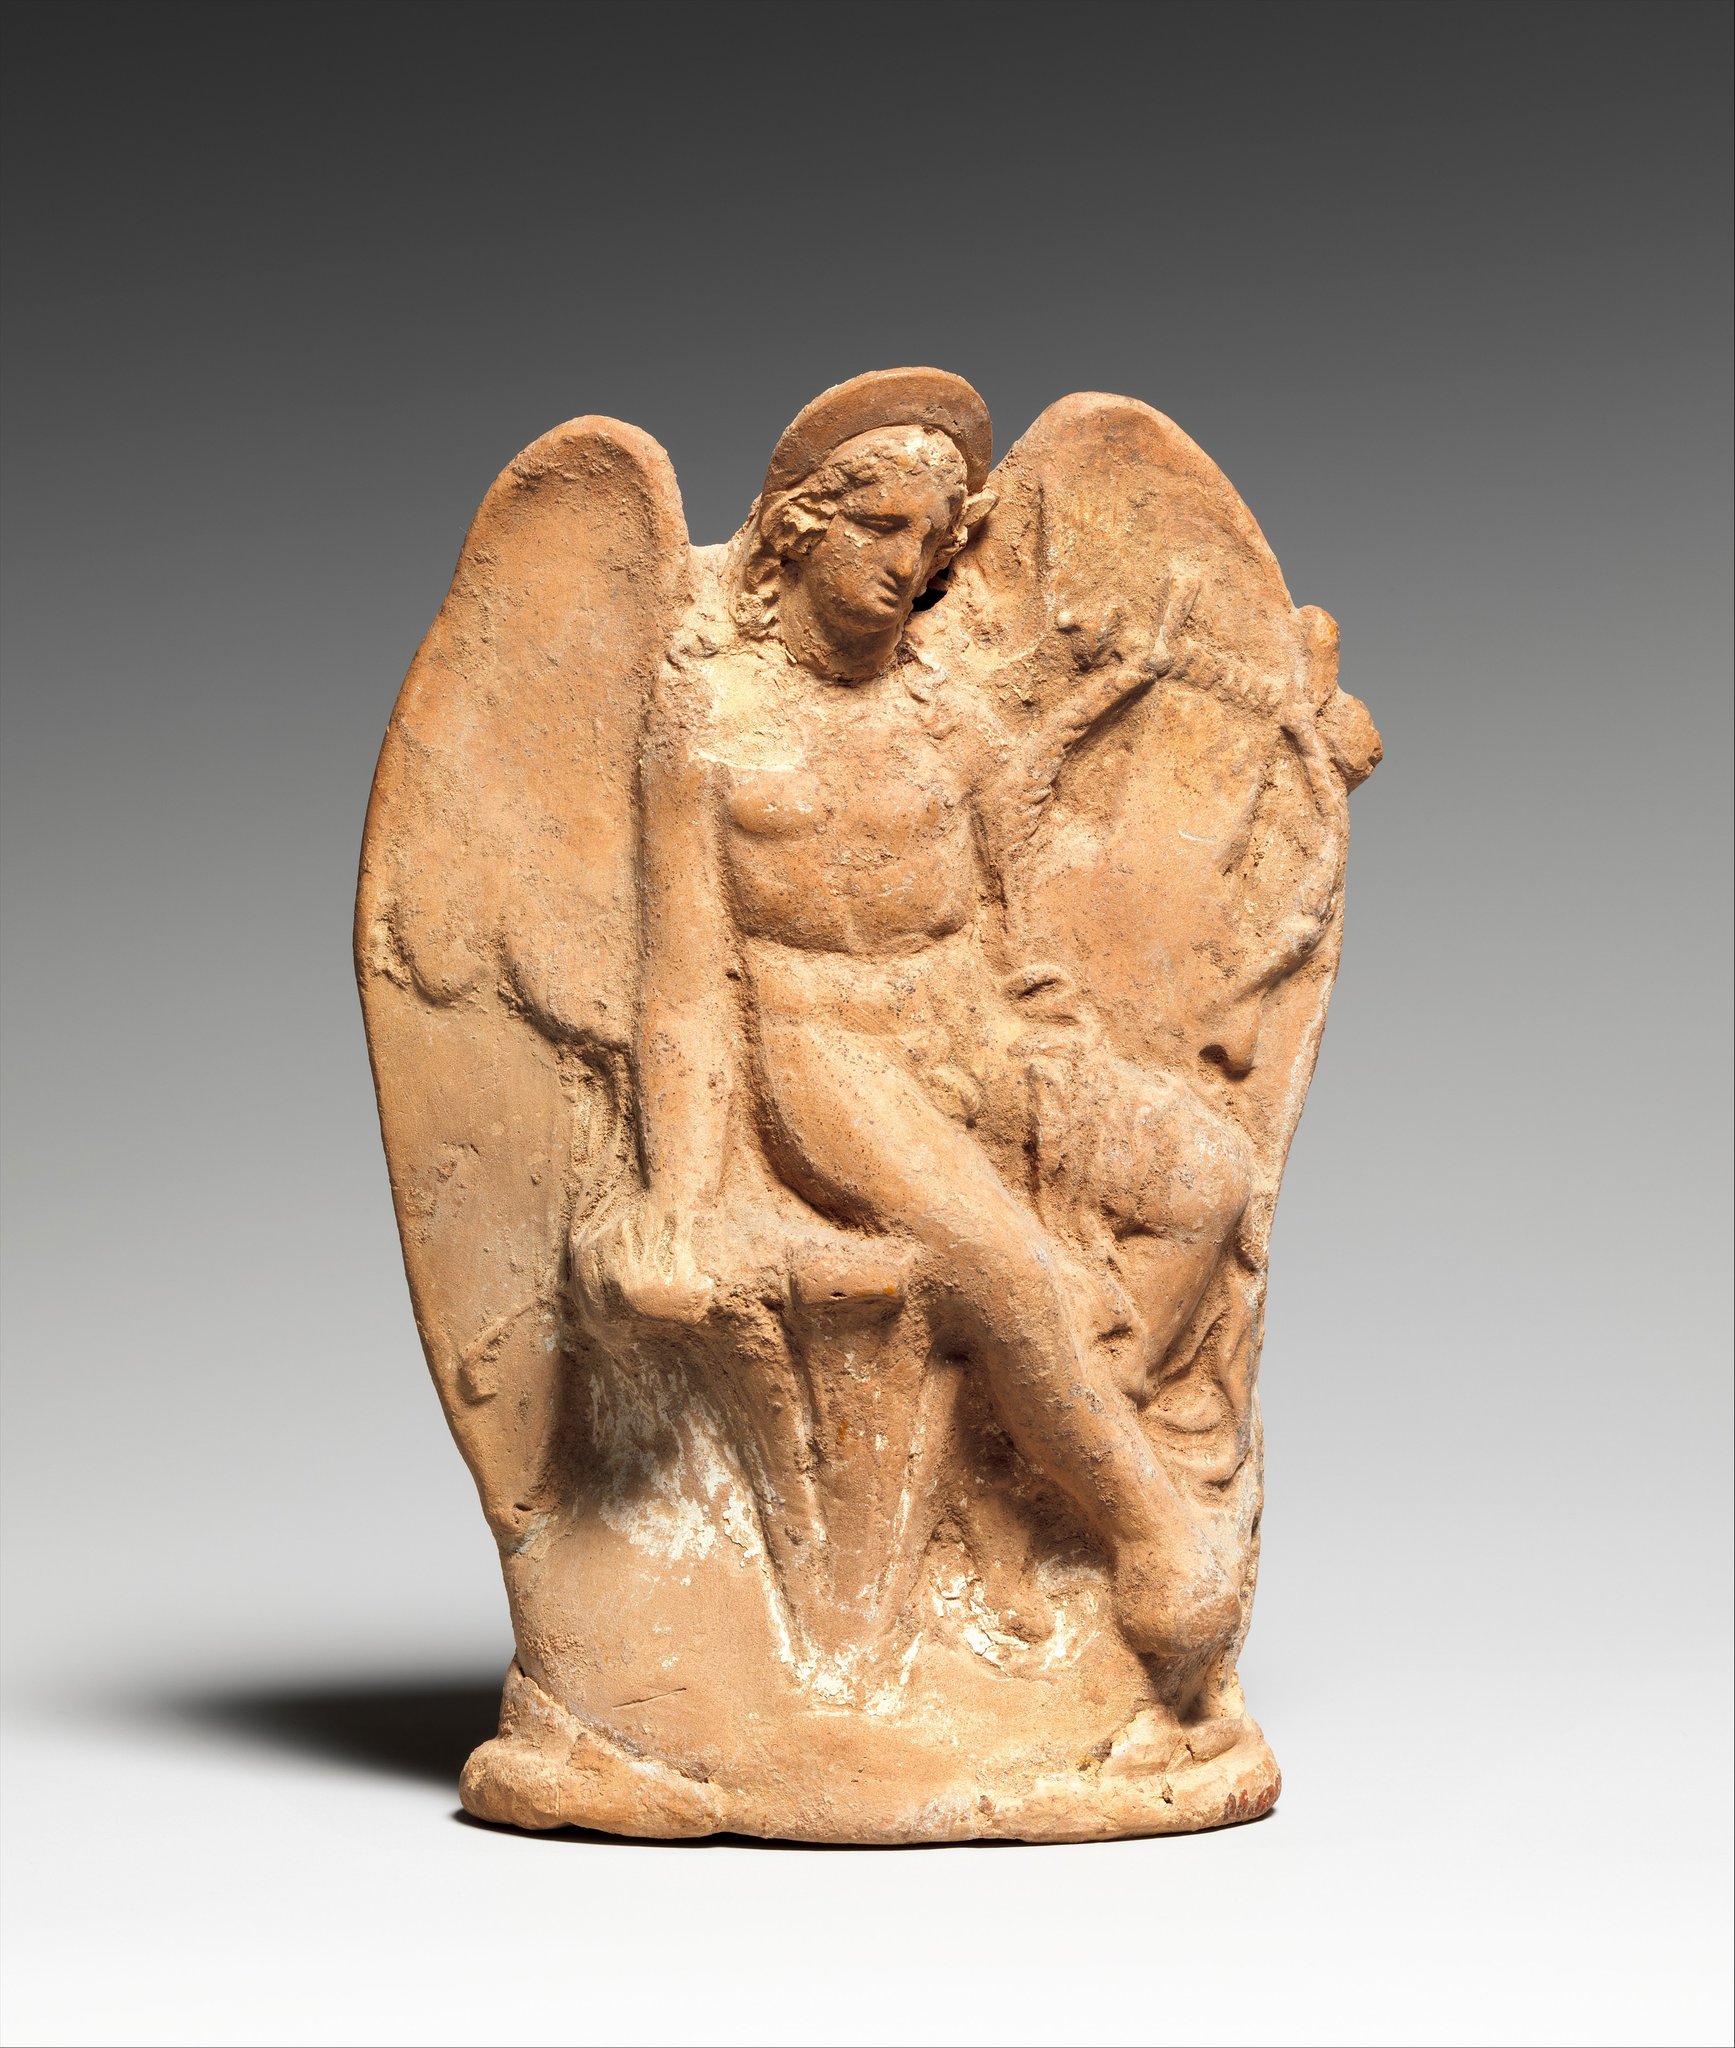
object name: seated eros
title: Terracotta Eros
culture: greek, attic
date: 400-351 BCE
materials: terracotta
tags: musical instruments,eros